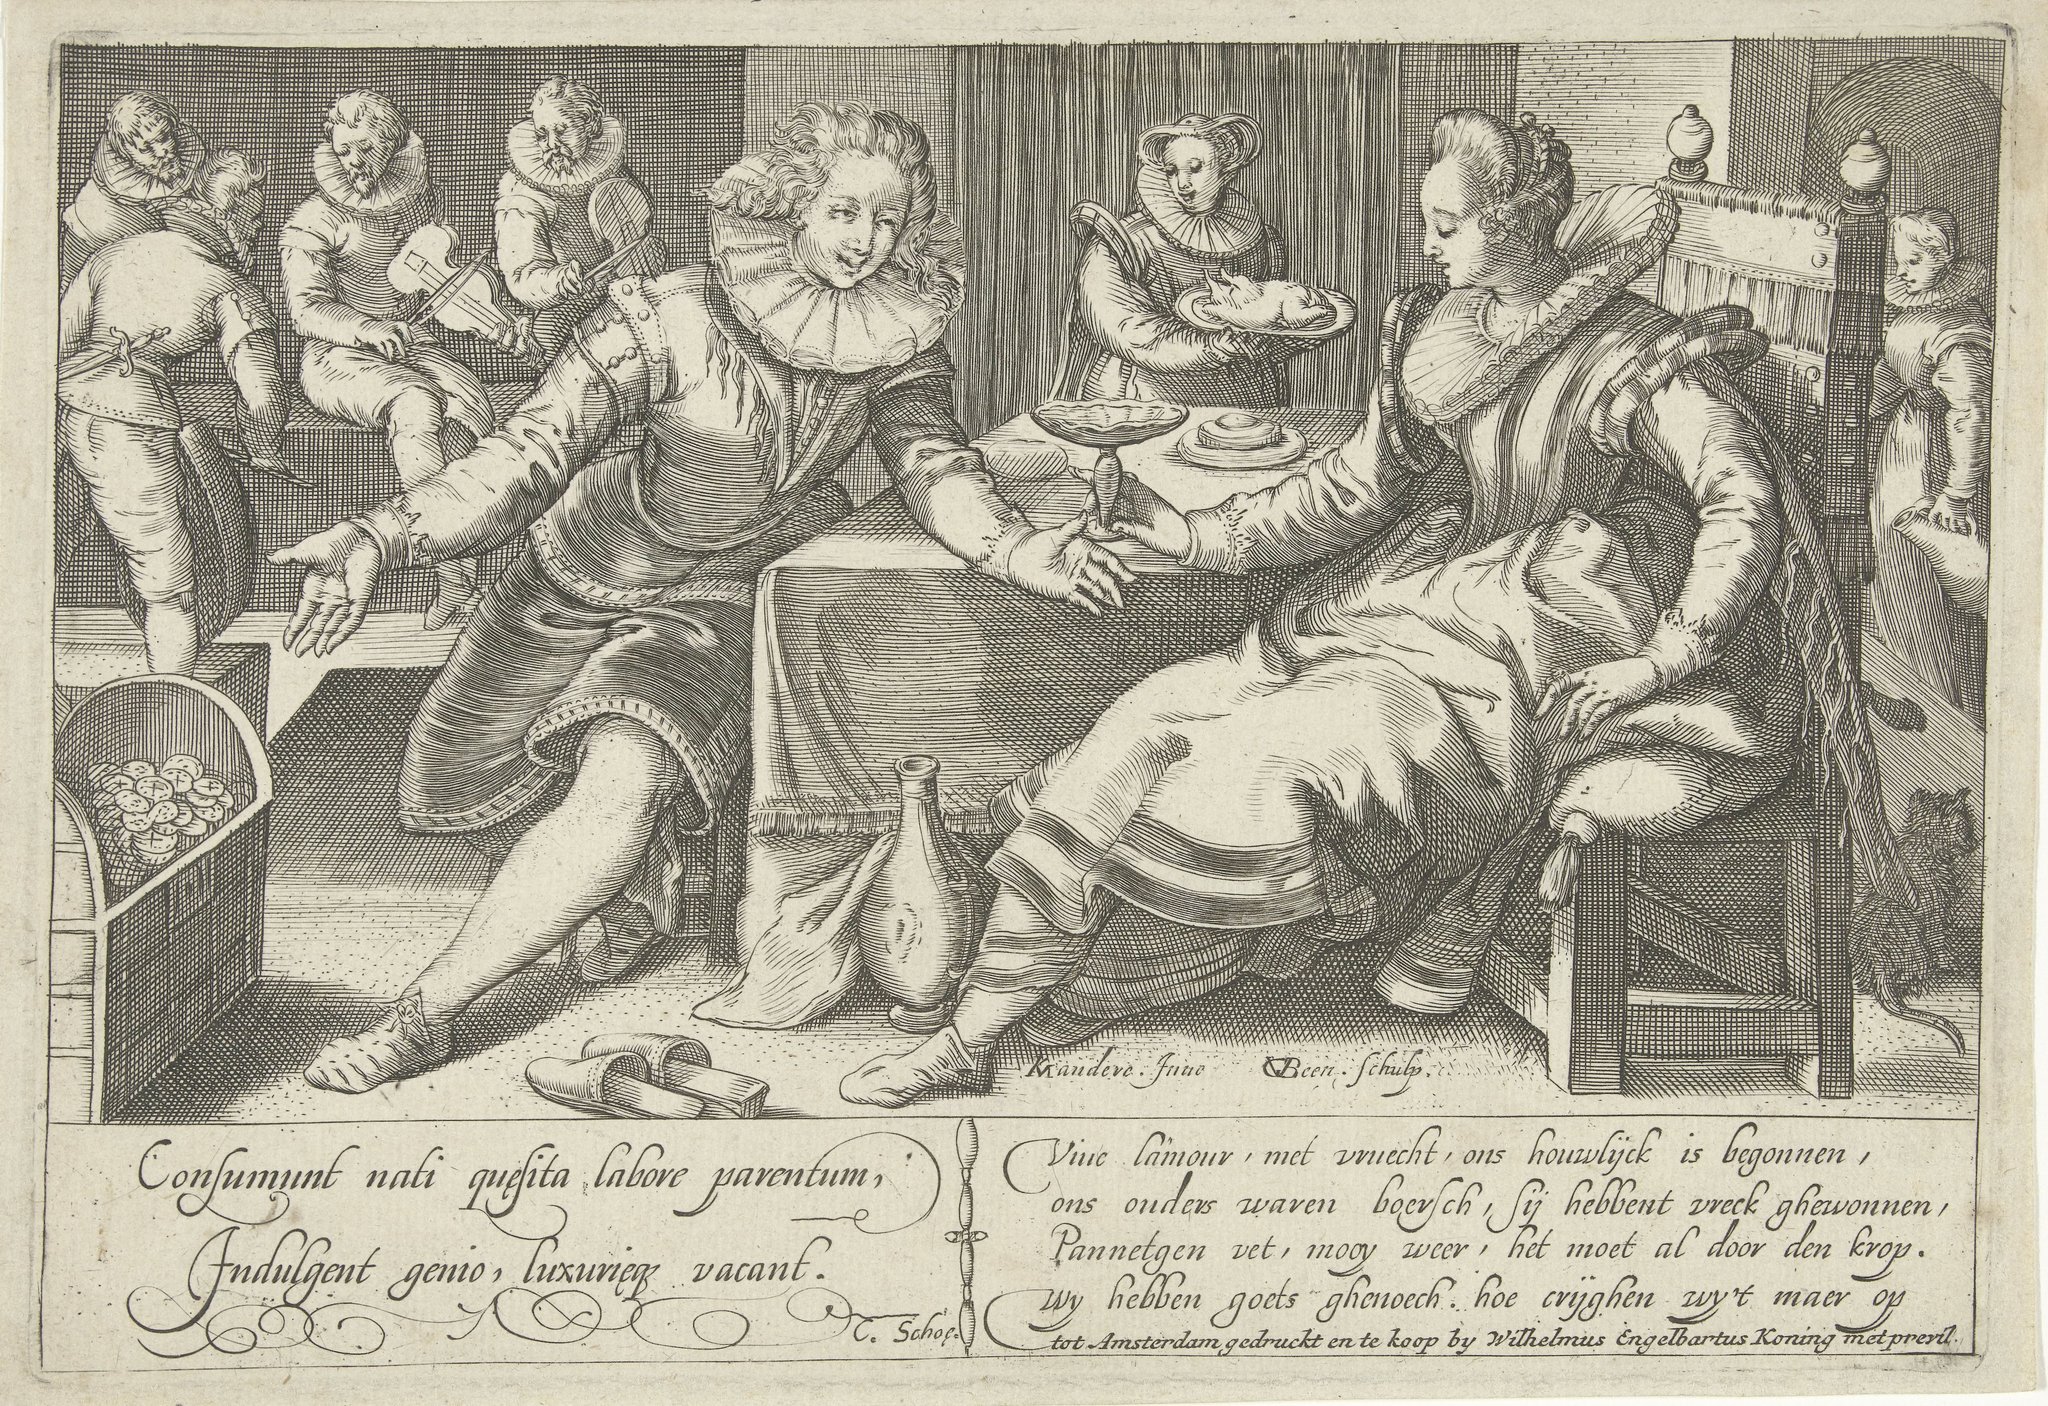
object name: print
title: Elegant paar aan tafel in een vertrek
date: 1595-1605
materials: paper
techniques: engraving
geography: amsterdam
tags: neck-gear ~ clothing (with name) (+ men's clothes), slippers, the rich, clothes, costume (+ women's clothes), shoes, sandals (+ women's clothes), neck-gear ~ clothing (with name) (+ women's clothes), skirt (+ women's clothes), dress, gown (+ women's clothes), wealth, opulence; 'opulenza', 'richezza' (ripa), shoes, sandals (+ men's clothes), clothes, costume (+ men's clothes), trousers, breeches, etc. (breeches) (+ men's clothes), clothing for the upper part of the body (doublet) (+ men's clothes), money-chest, treasure-chest, money-box, happy marriage, clothing for the upper part of the body (with name) (+ women's clothes), more than one musician with instrument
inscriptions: collector's mark: Lugt 2228, signature: ‘CVBreen schulp.’, signature: ‘KMander Inve.’, caption: ‘Vive lamour, met vruecht, ons houwelijck is begonnen / ons ouders waren boersch, sij hebbent vreck ghewonnen / pannetgen vet, mooy weer, het moet al door den krop / Wij hebben goets ghenoech, hoe crijghen wijt maer op.’, caption: ‘Consumunt nati quesita....vacant’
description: Kleding: de man draagt een wambuis met brede geplooide kraag*, broek* met cilindervormige pijpen en splittenschoenen*. De vrouw is gekleed in een lijfje* met verticaal strepenpatroon, schouderwielen* en siermouwen*. Brede lubbenkraag*. Onderrok* met horizontale strepen aan de onderrand. Aan haar voeten splittenschoenen*. Twee muilen* op de grond.